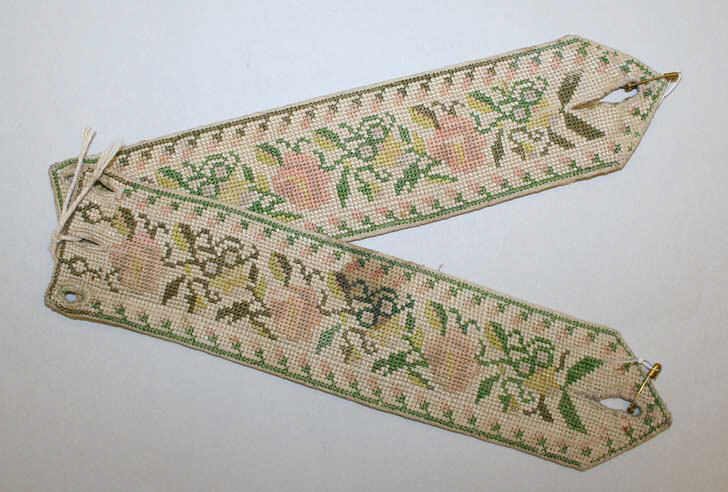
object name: suspender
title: Suspenders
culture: european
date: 1801-1900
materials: linen, silk